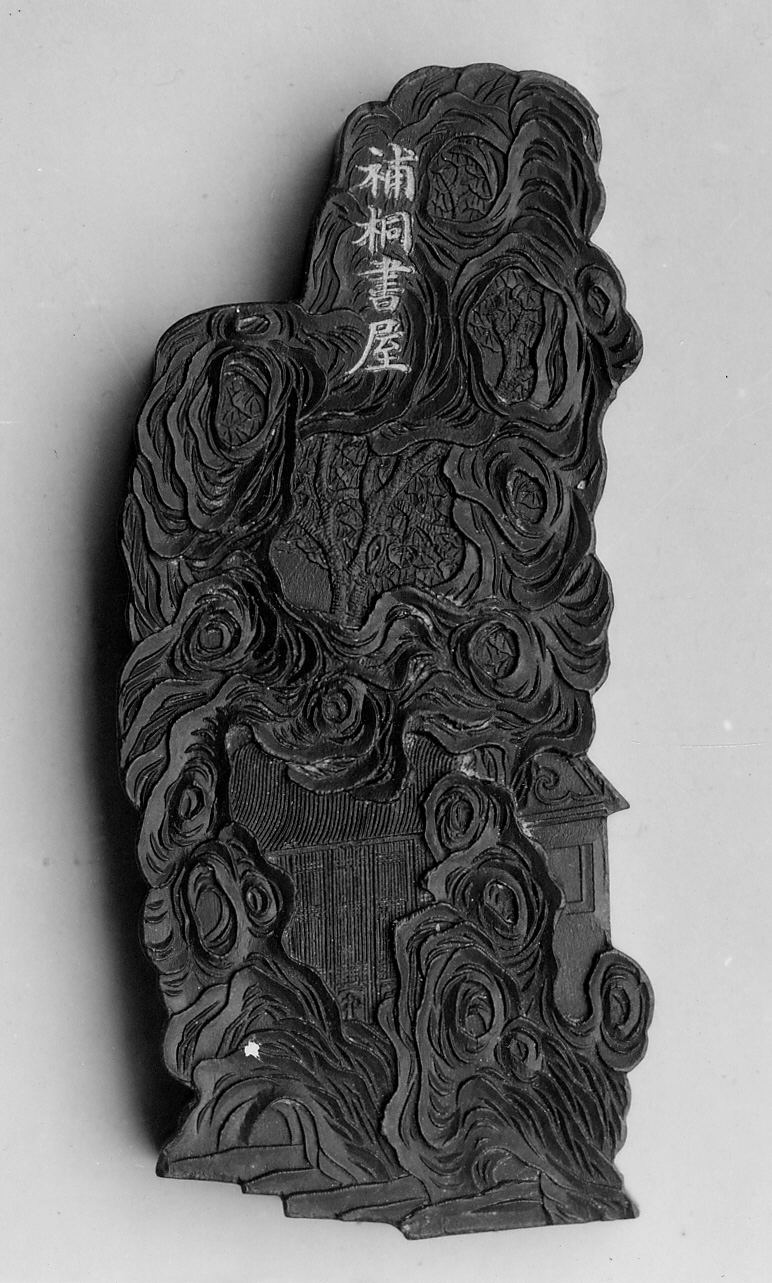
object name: ink tablet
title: Replanted Tree Library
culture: chinese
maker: jian guzhai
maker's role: artist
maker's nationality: chinese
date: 1867-1933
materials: gilt, wood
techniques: bookbinding